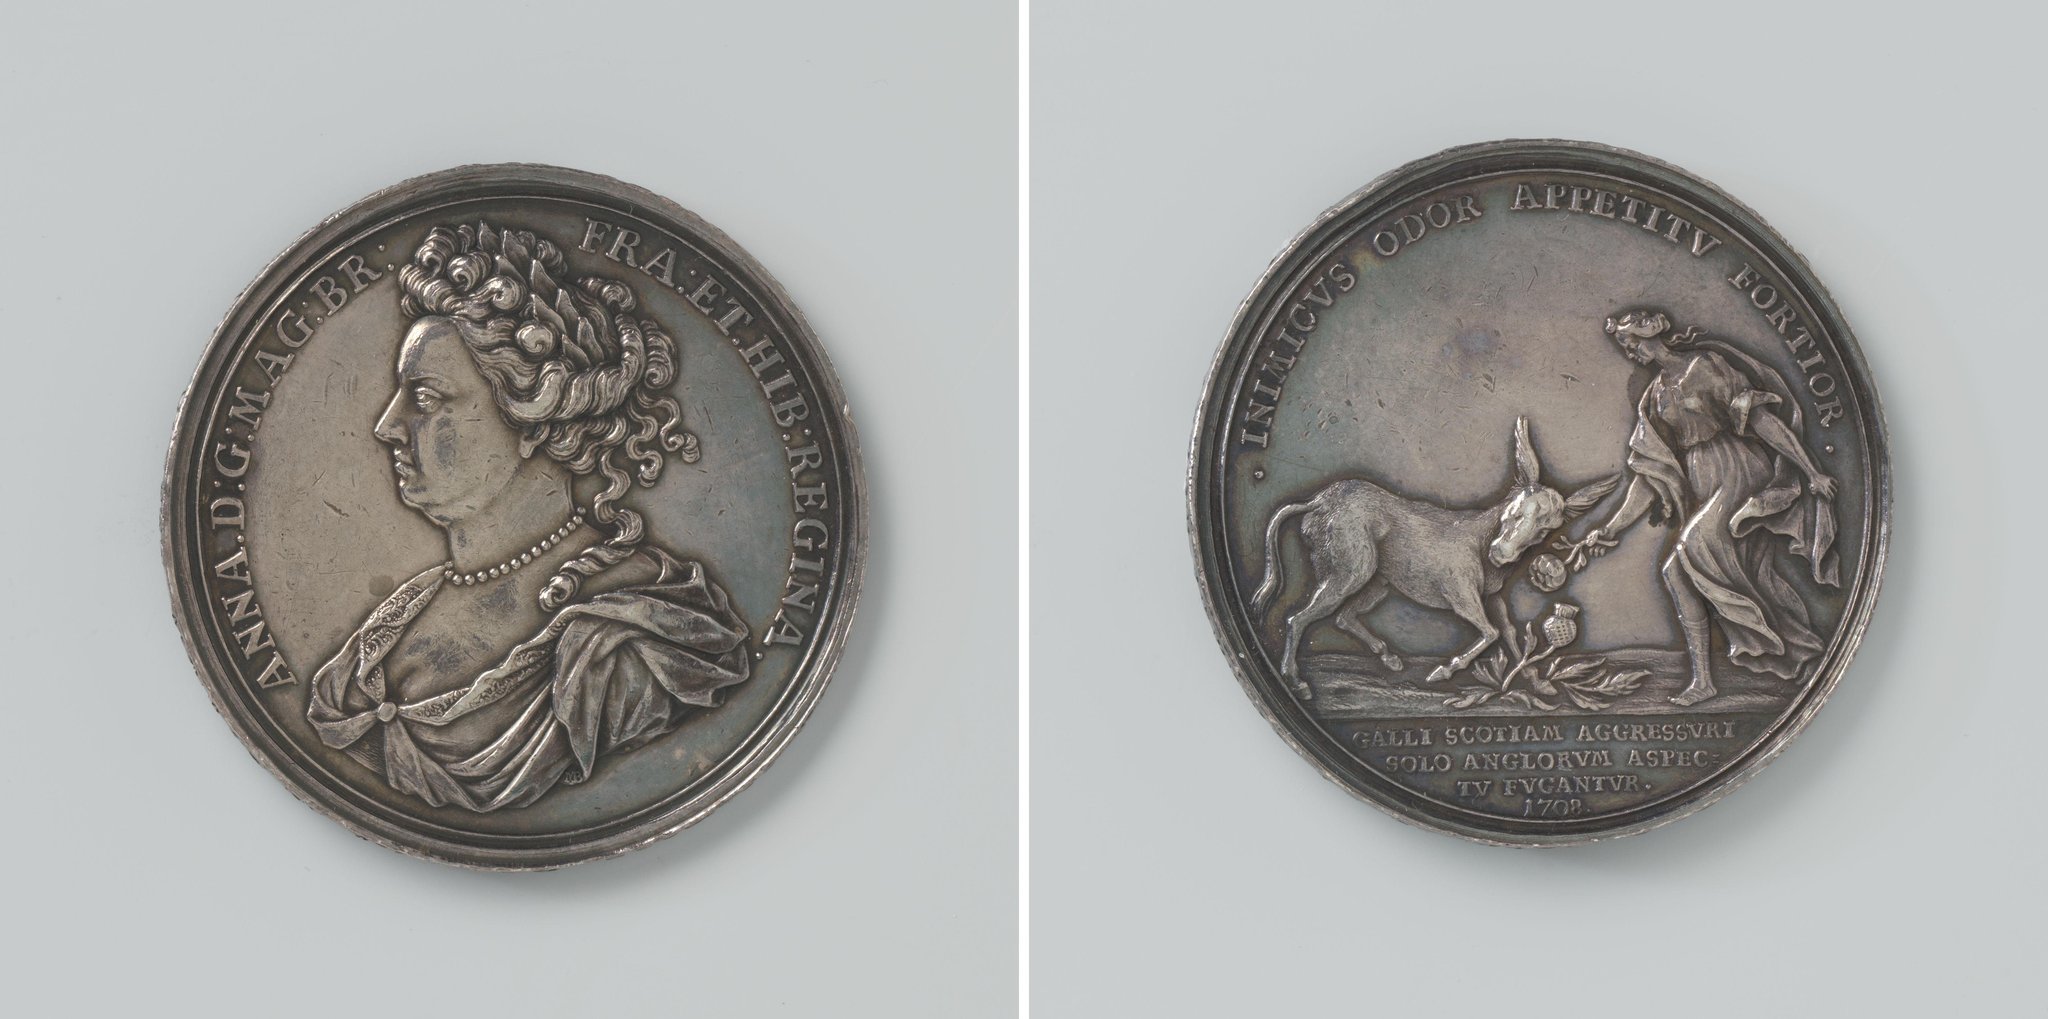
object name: medal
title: Mislukte invasie van Jacobus III in Schotland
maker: martin brunner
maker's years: 1659-1725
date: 1708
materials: silver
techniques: striking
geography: nuremberg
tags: jacobus iii (koning van engeland en schotland), schotland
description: Buste van Koningin Anne / ezel die Schotse distel wil eten, wordt verjaagd door vrouw die hem roos voor neus houdt.